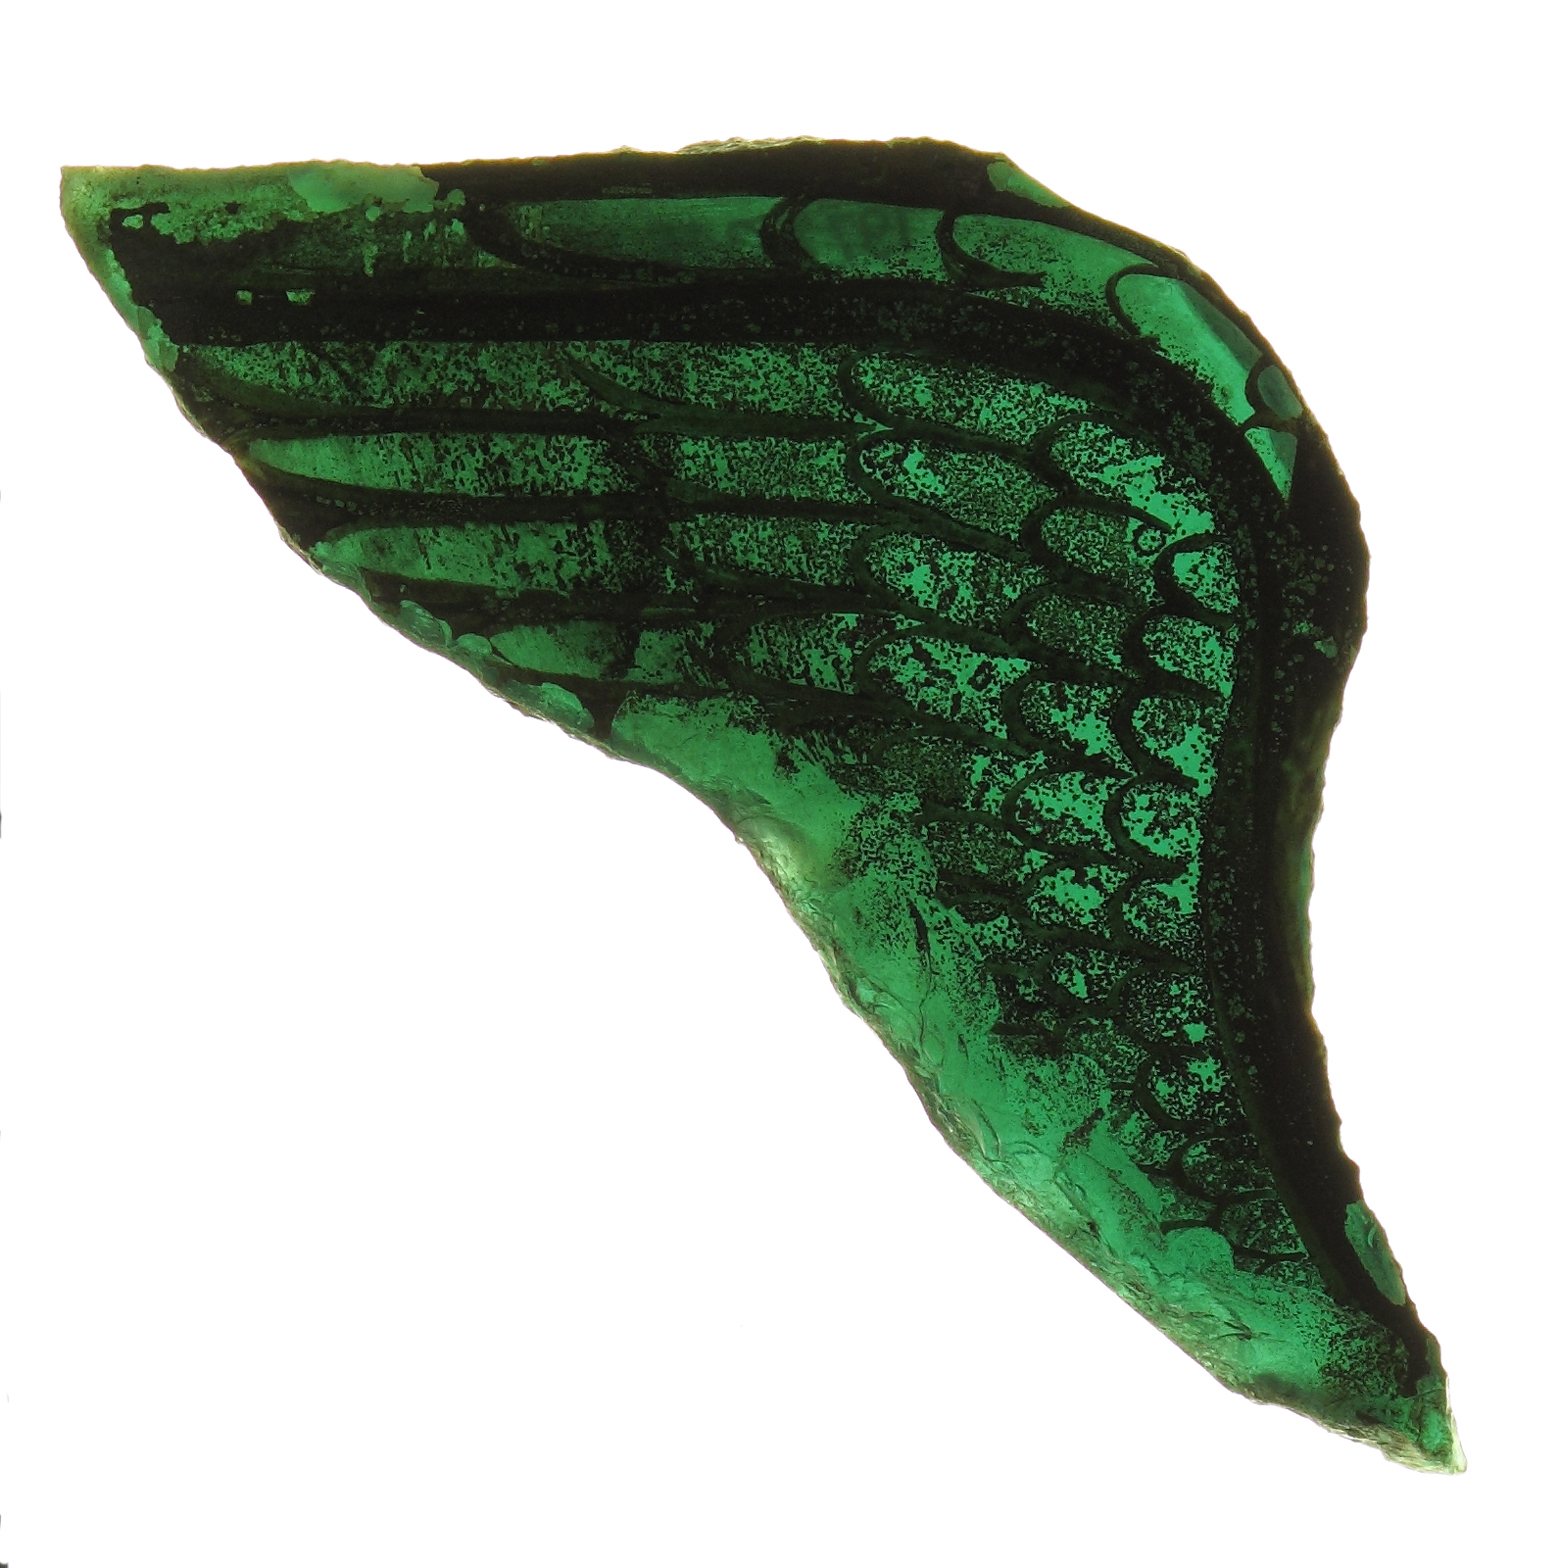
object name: fragment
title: Glass Fragment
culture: french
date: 1101-1400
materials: glass, metal, paint